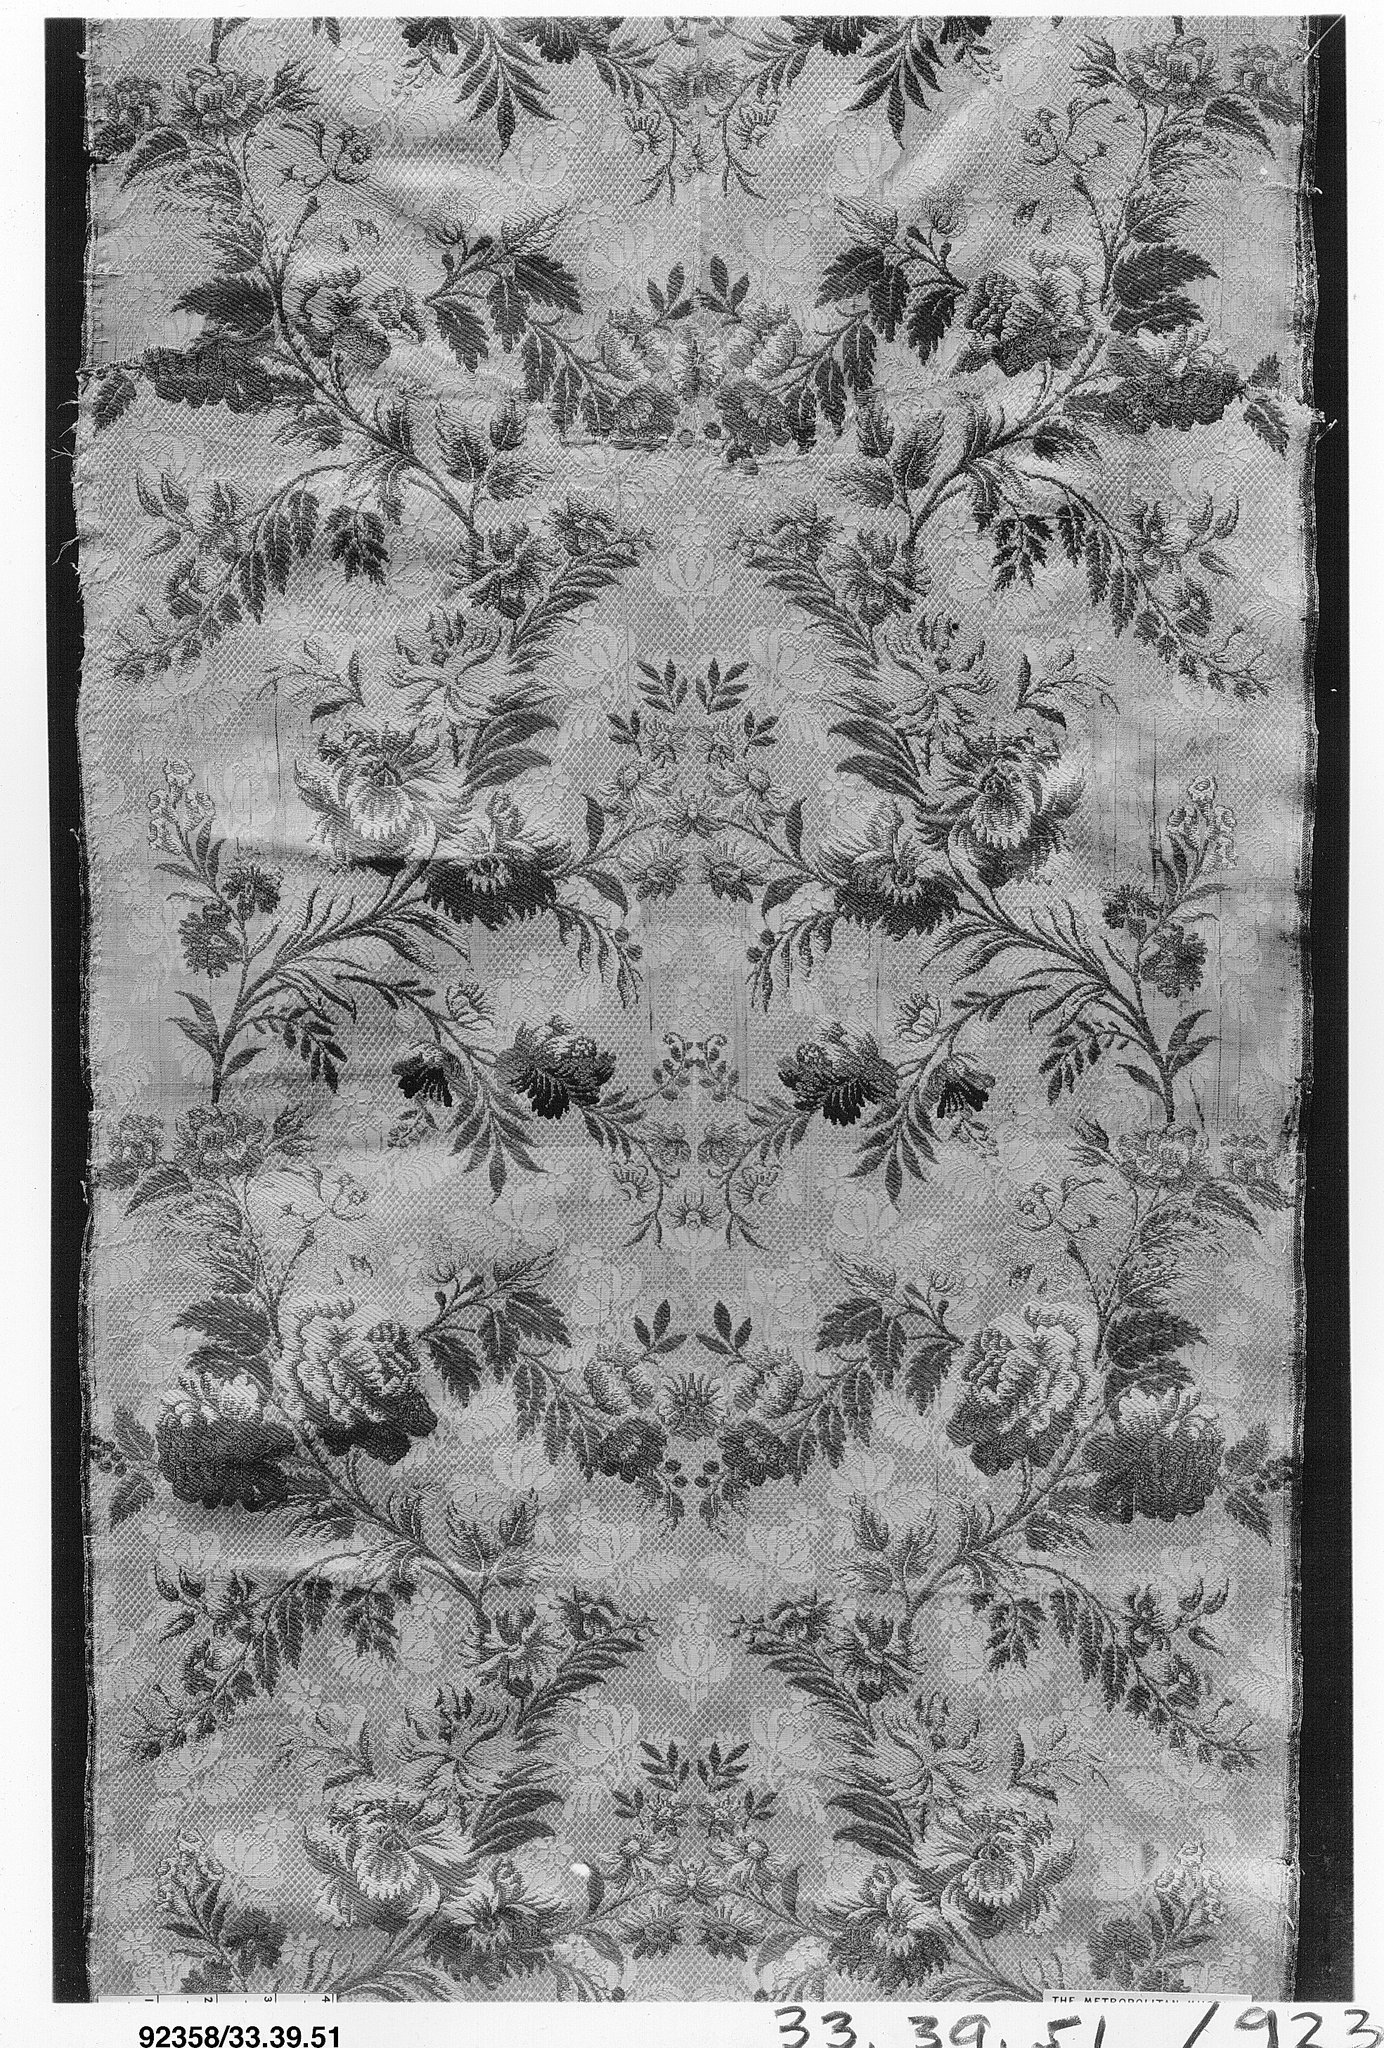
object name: fragment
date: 1725-1730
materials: silk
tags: flowers,leaves